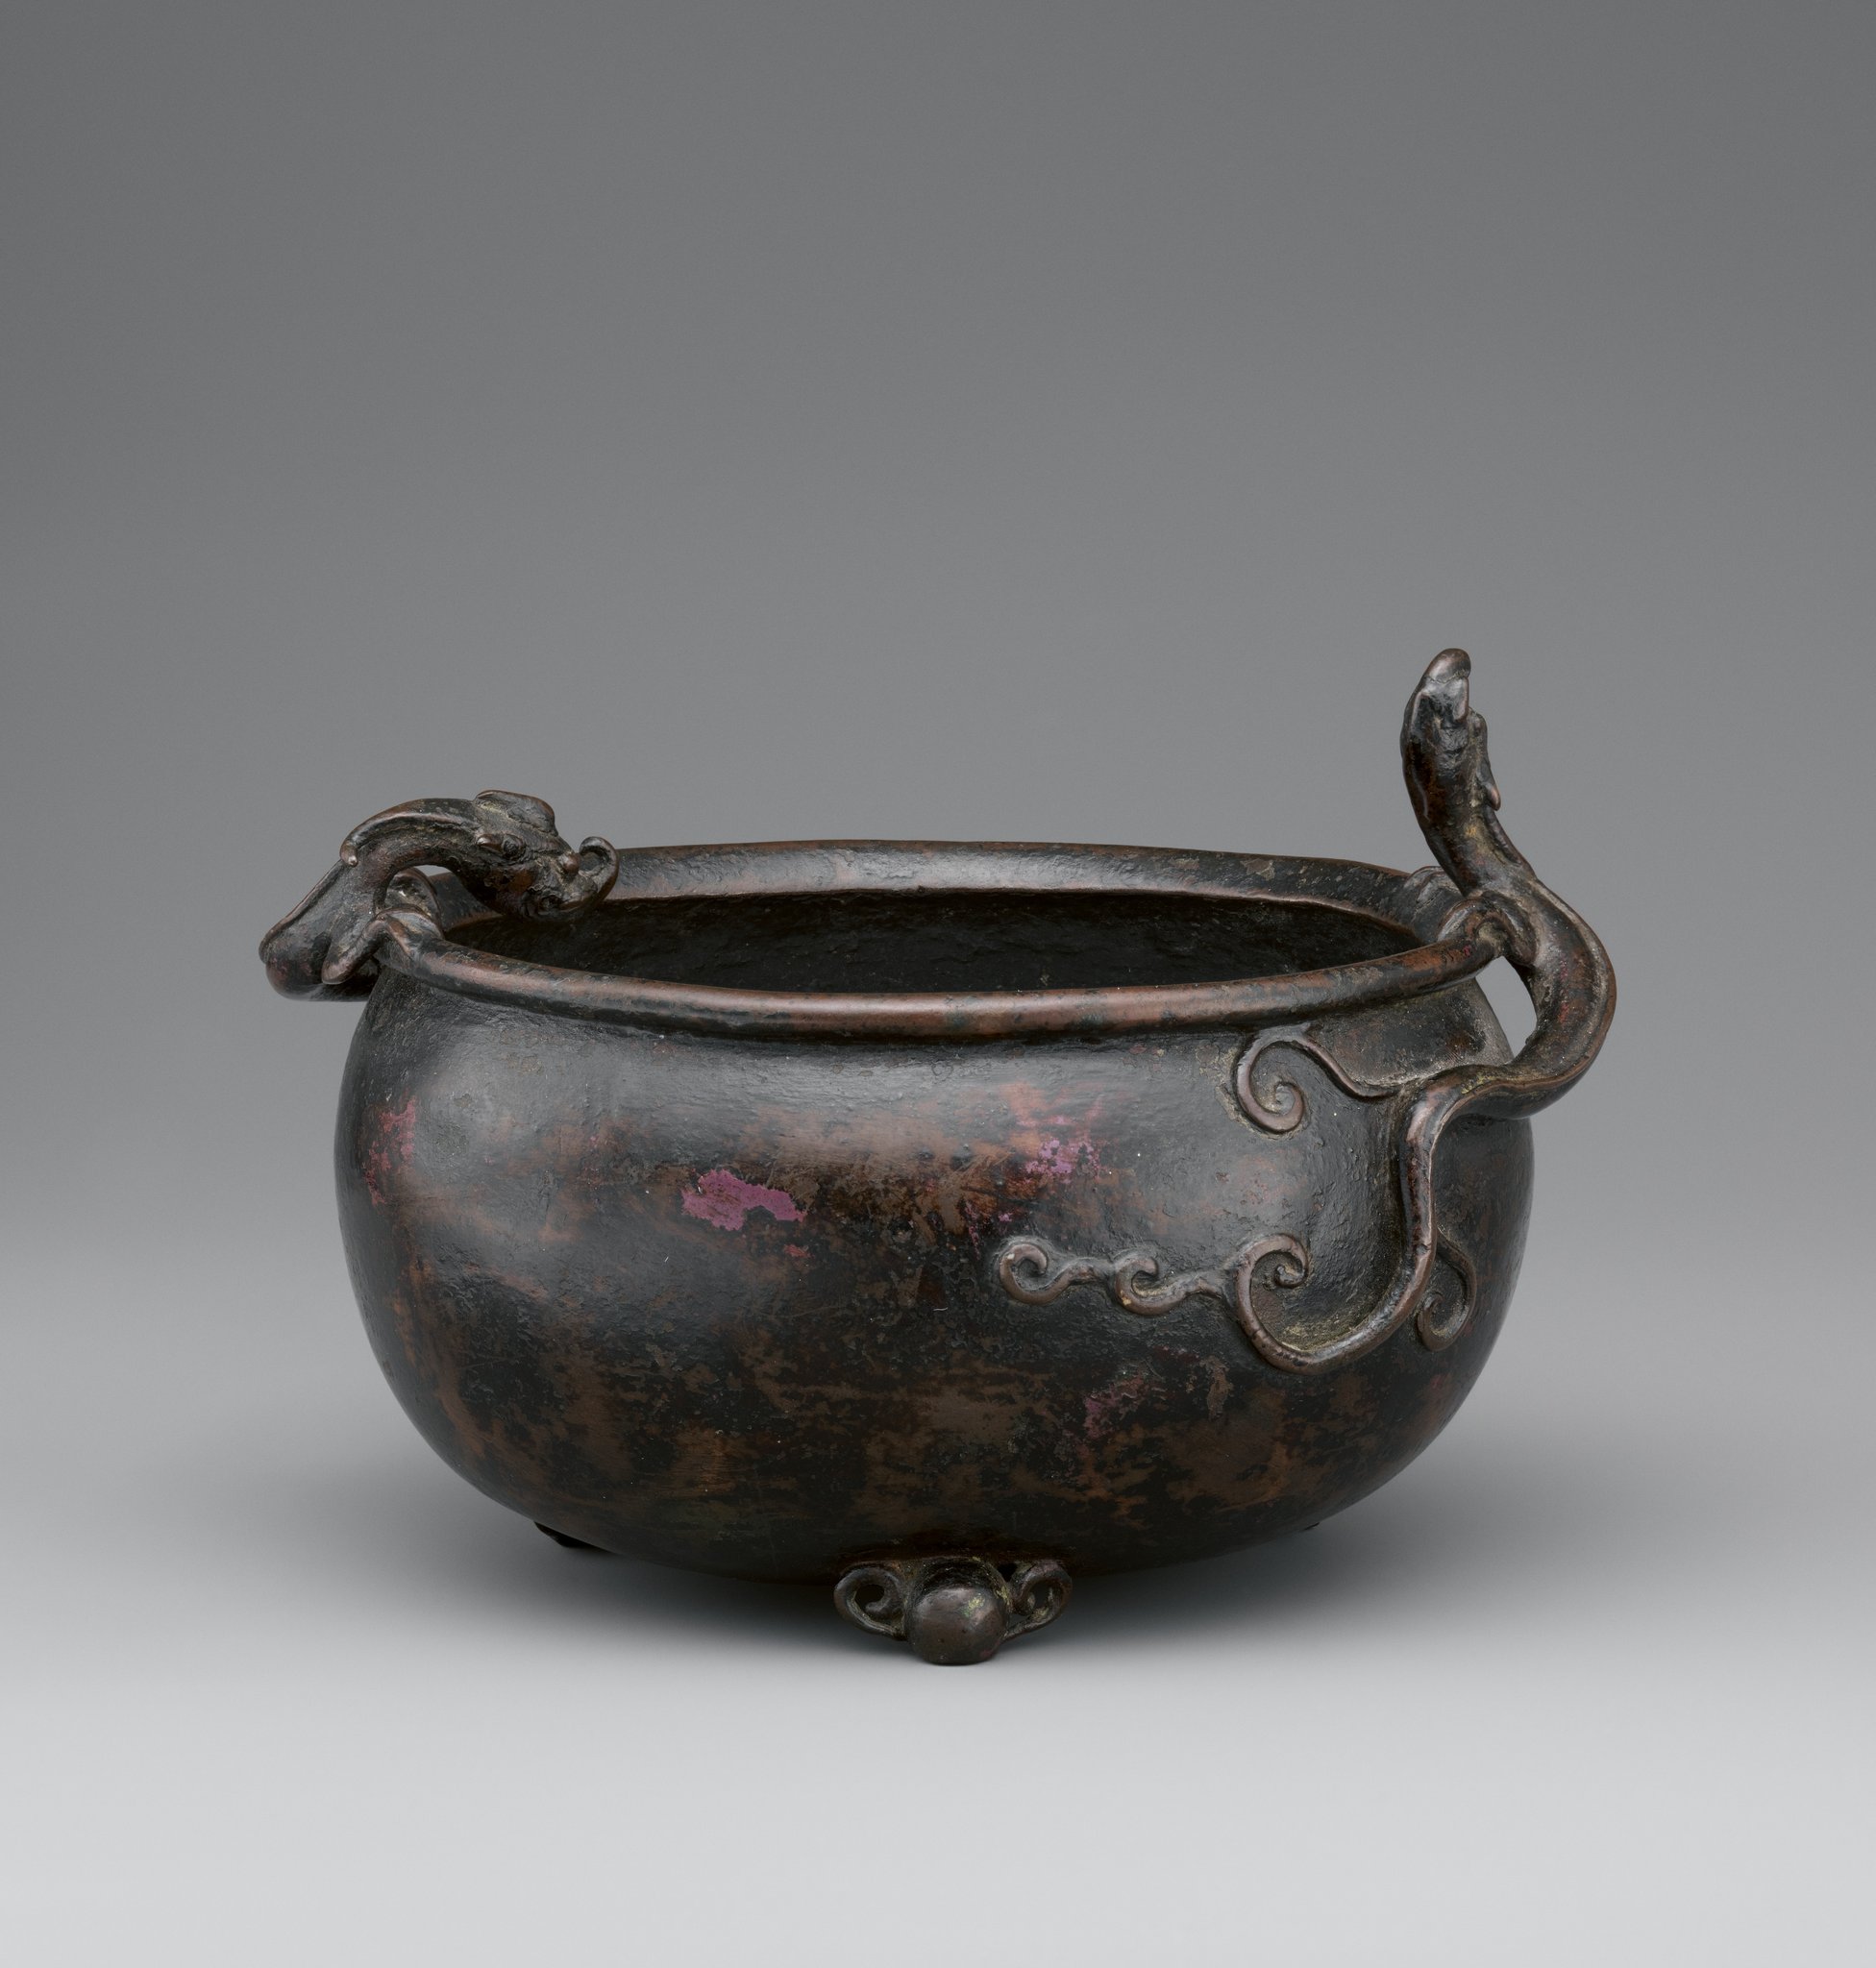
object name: brush washer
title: Brush washer with twin dragons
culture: chinese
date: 1301-1400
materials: copper alloy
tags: dragons